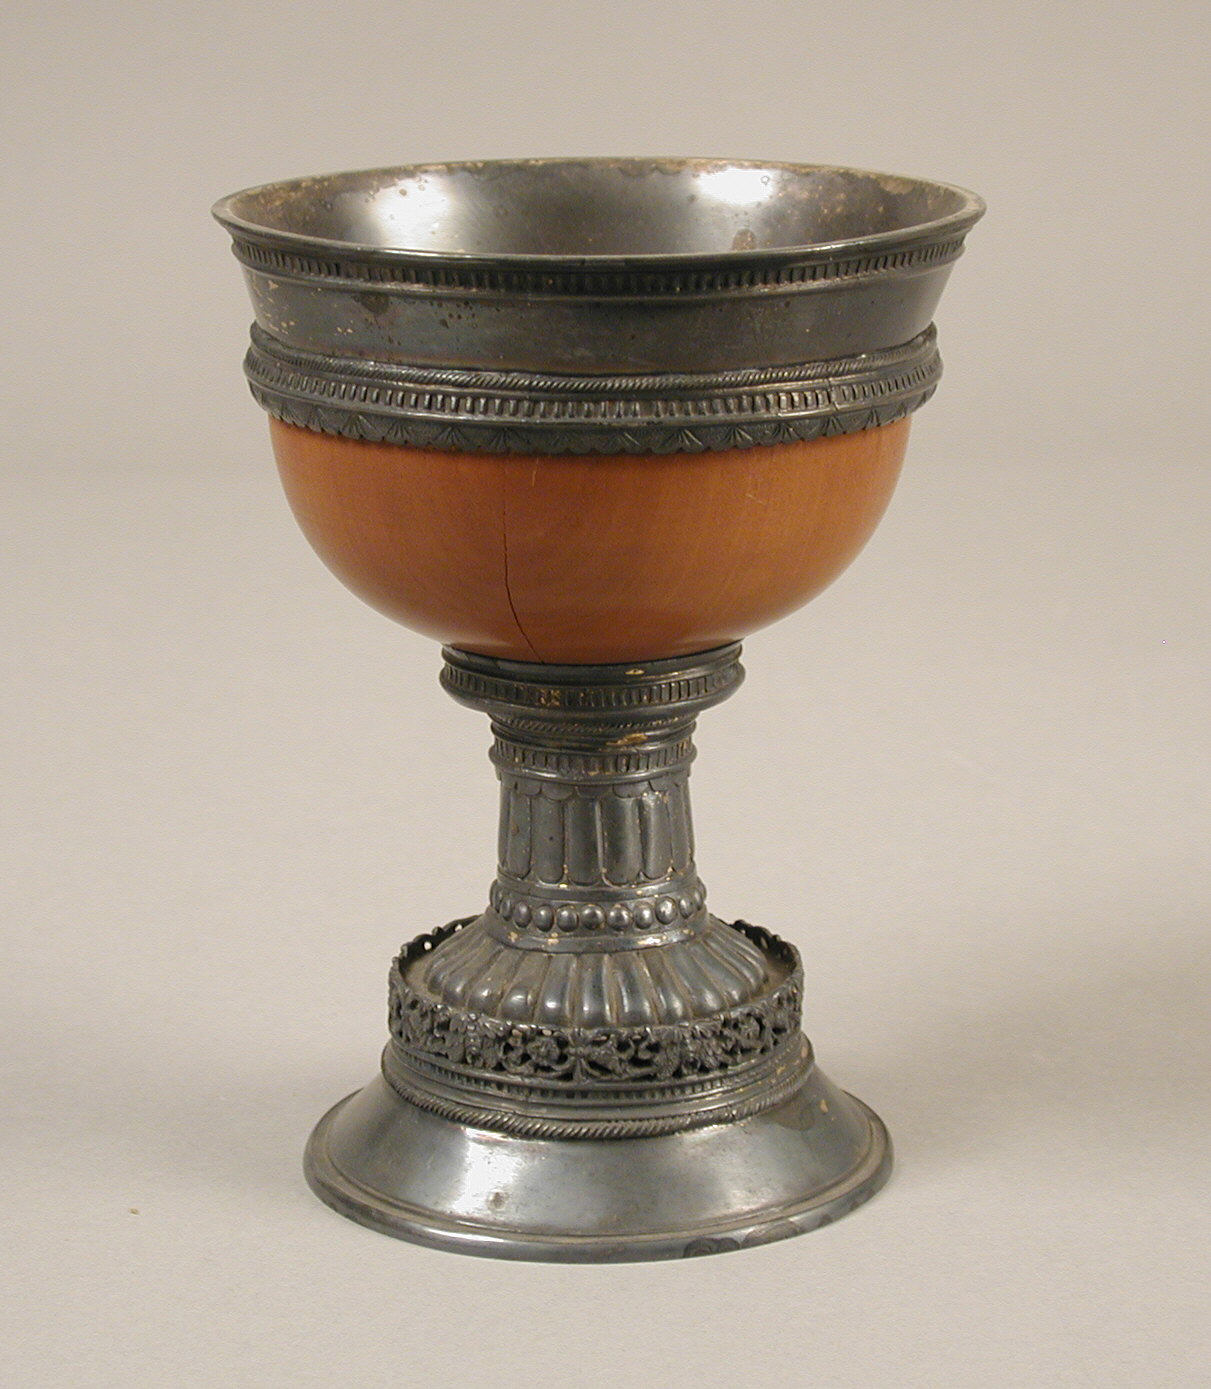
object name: mazer bowl and foot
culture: british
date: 1901-1933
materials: wood, silver gilt